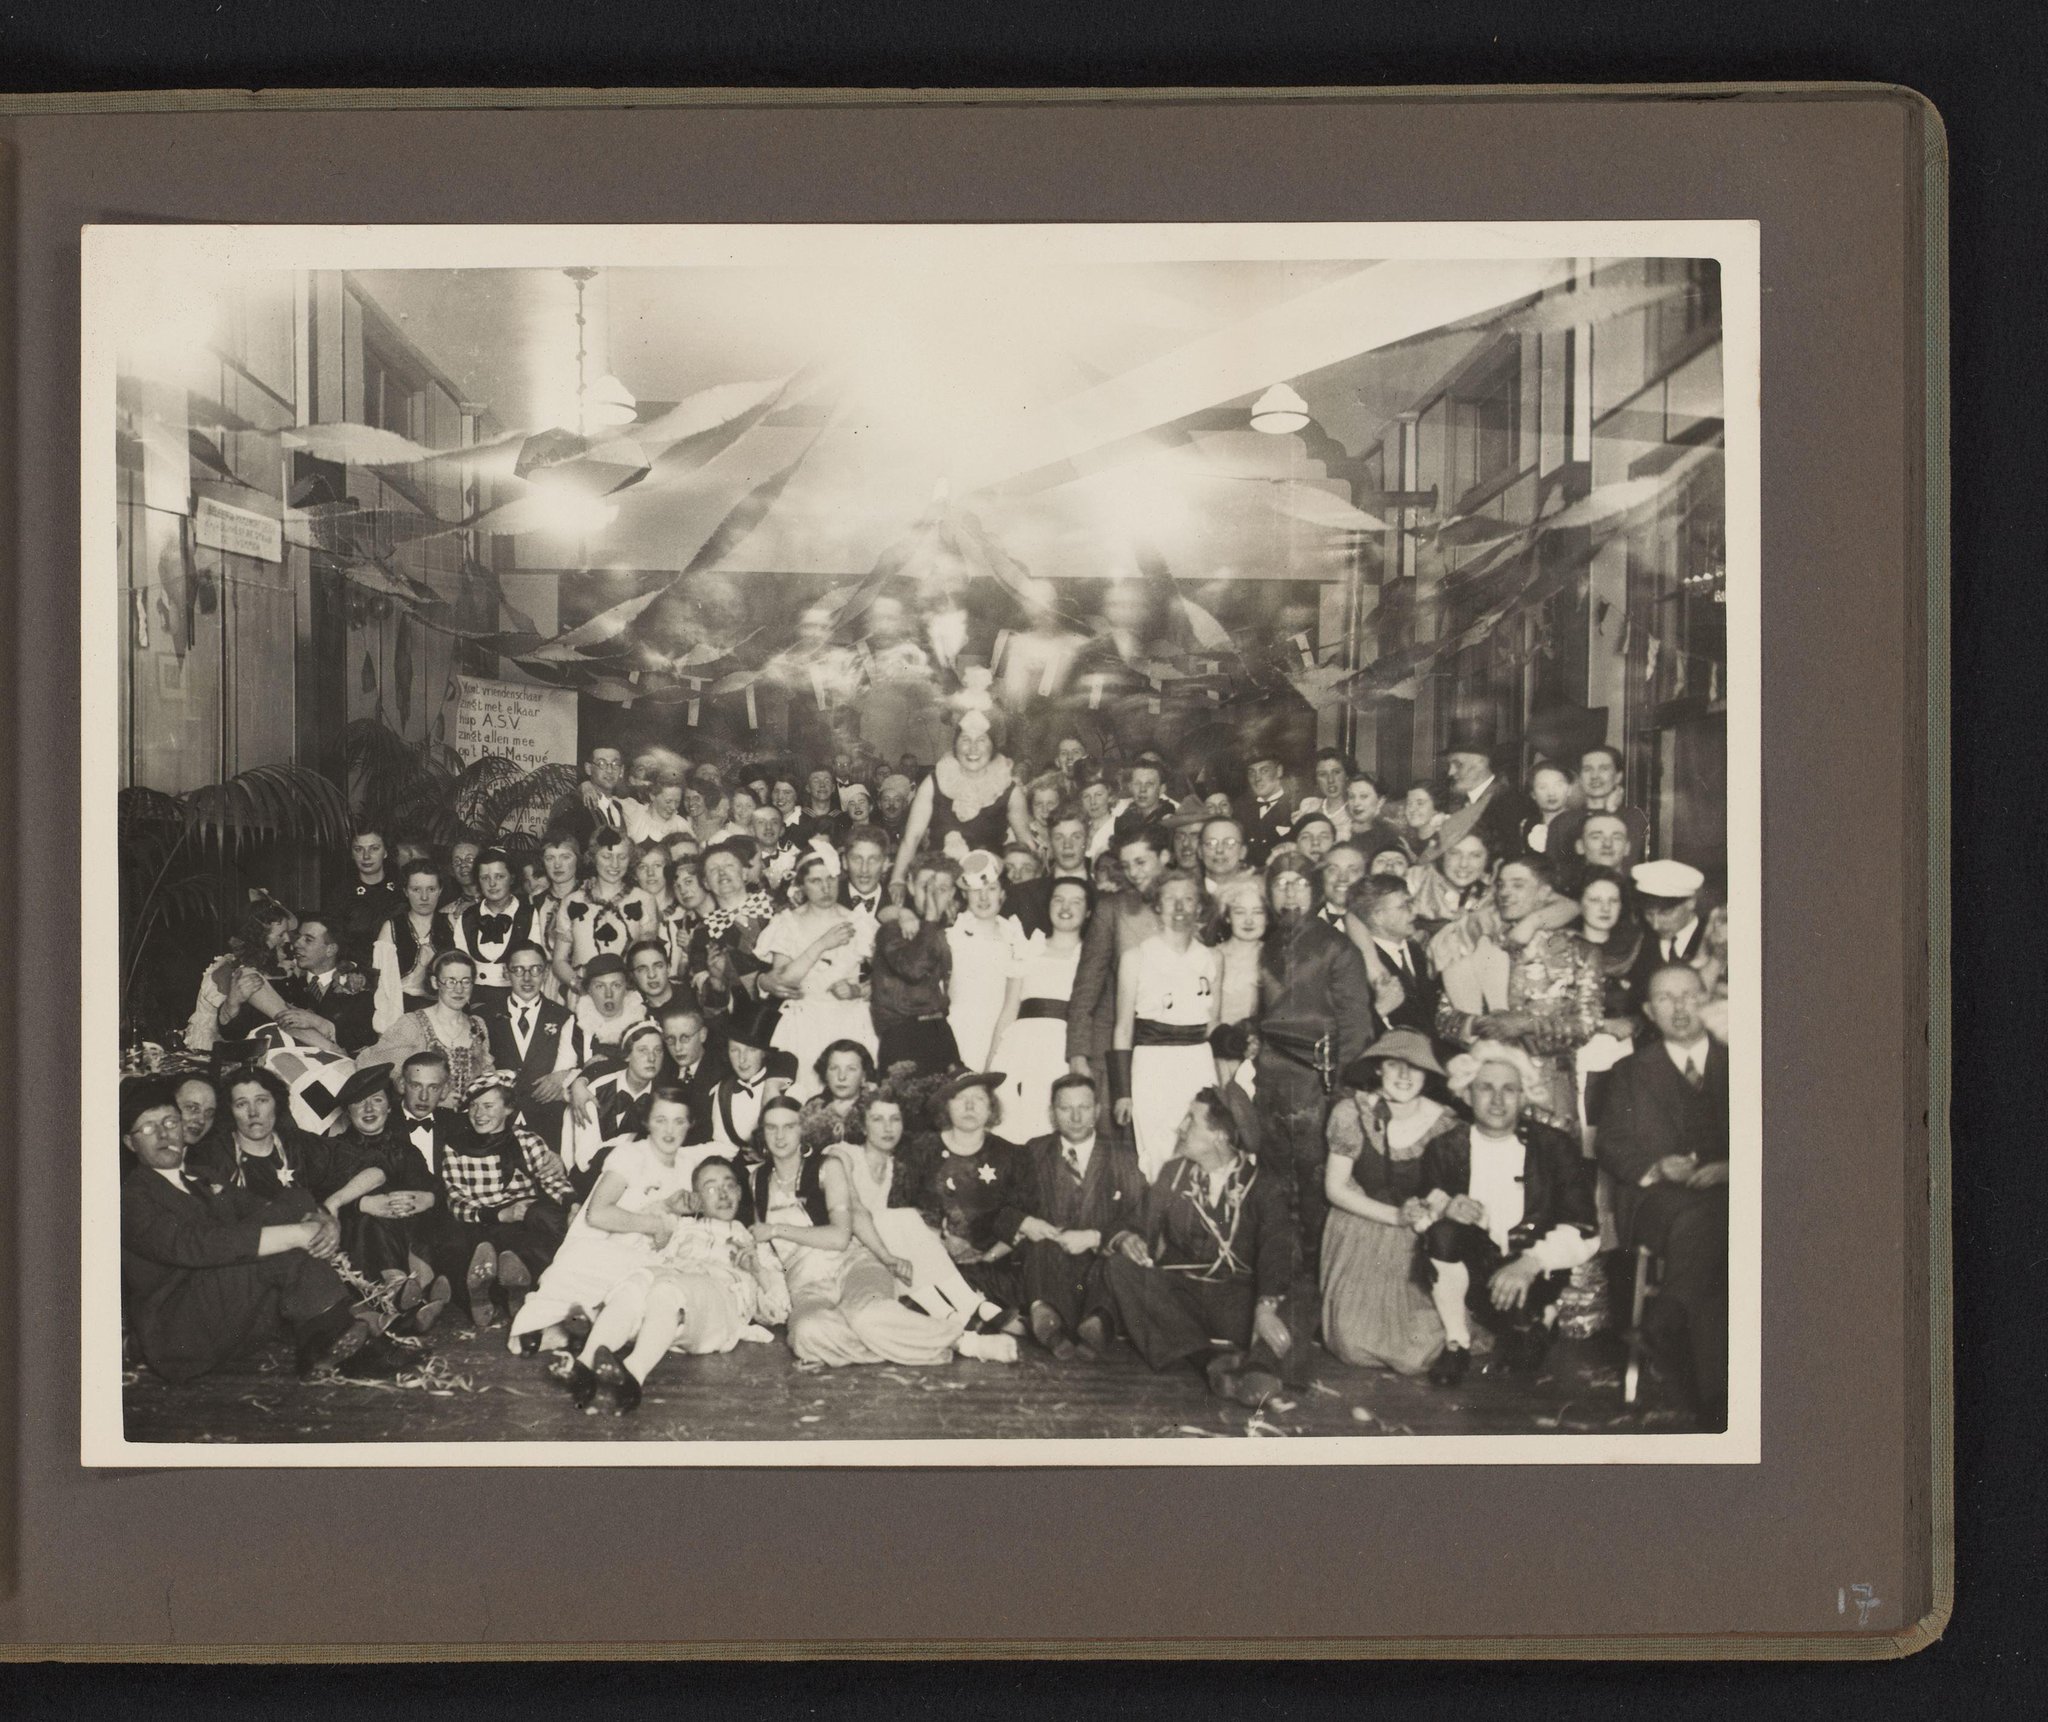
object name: photograph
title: Bal-Masqué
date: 1942-1945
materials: cardboard, photographic support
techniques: gelatin silver print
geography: netherlands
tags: party (students), masquerade, masked ball, netherlands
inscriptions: copyright notice: ‘Foto Pers Bureau Schiedam. Passage 10-12 - Tef. 67520’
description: Albumblad met een losse foto van een verkleed en vrolijk gezelschap op een bal masqué. Links hangt een spandoek met de tekst 'Komt vriendenschaar, zingt met elkaar, hup A.S.V., zingt allen mee, op 't Bal-Masqué'. Enkele personen zittend op de eerste rij dragen een jodenster op hun kleding.